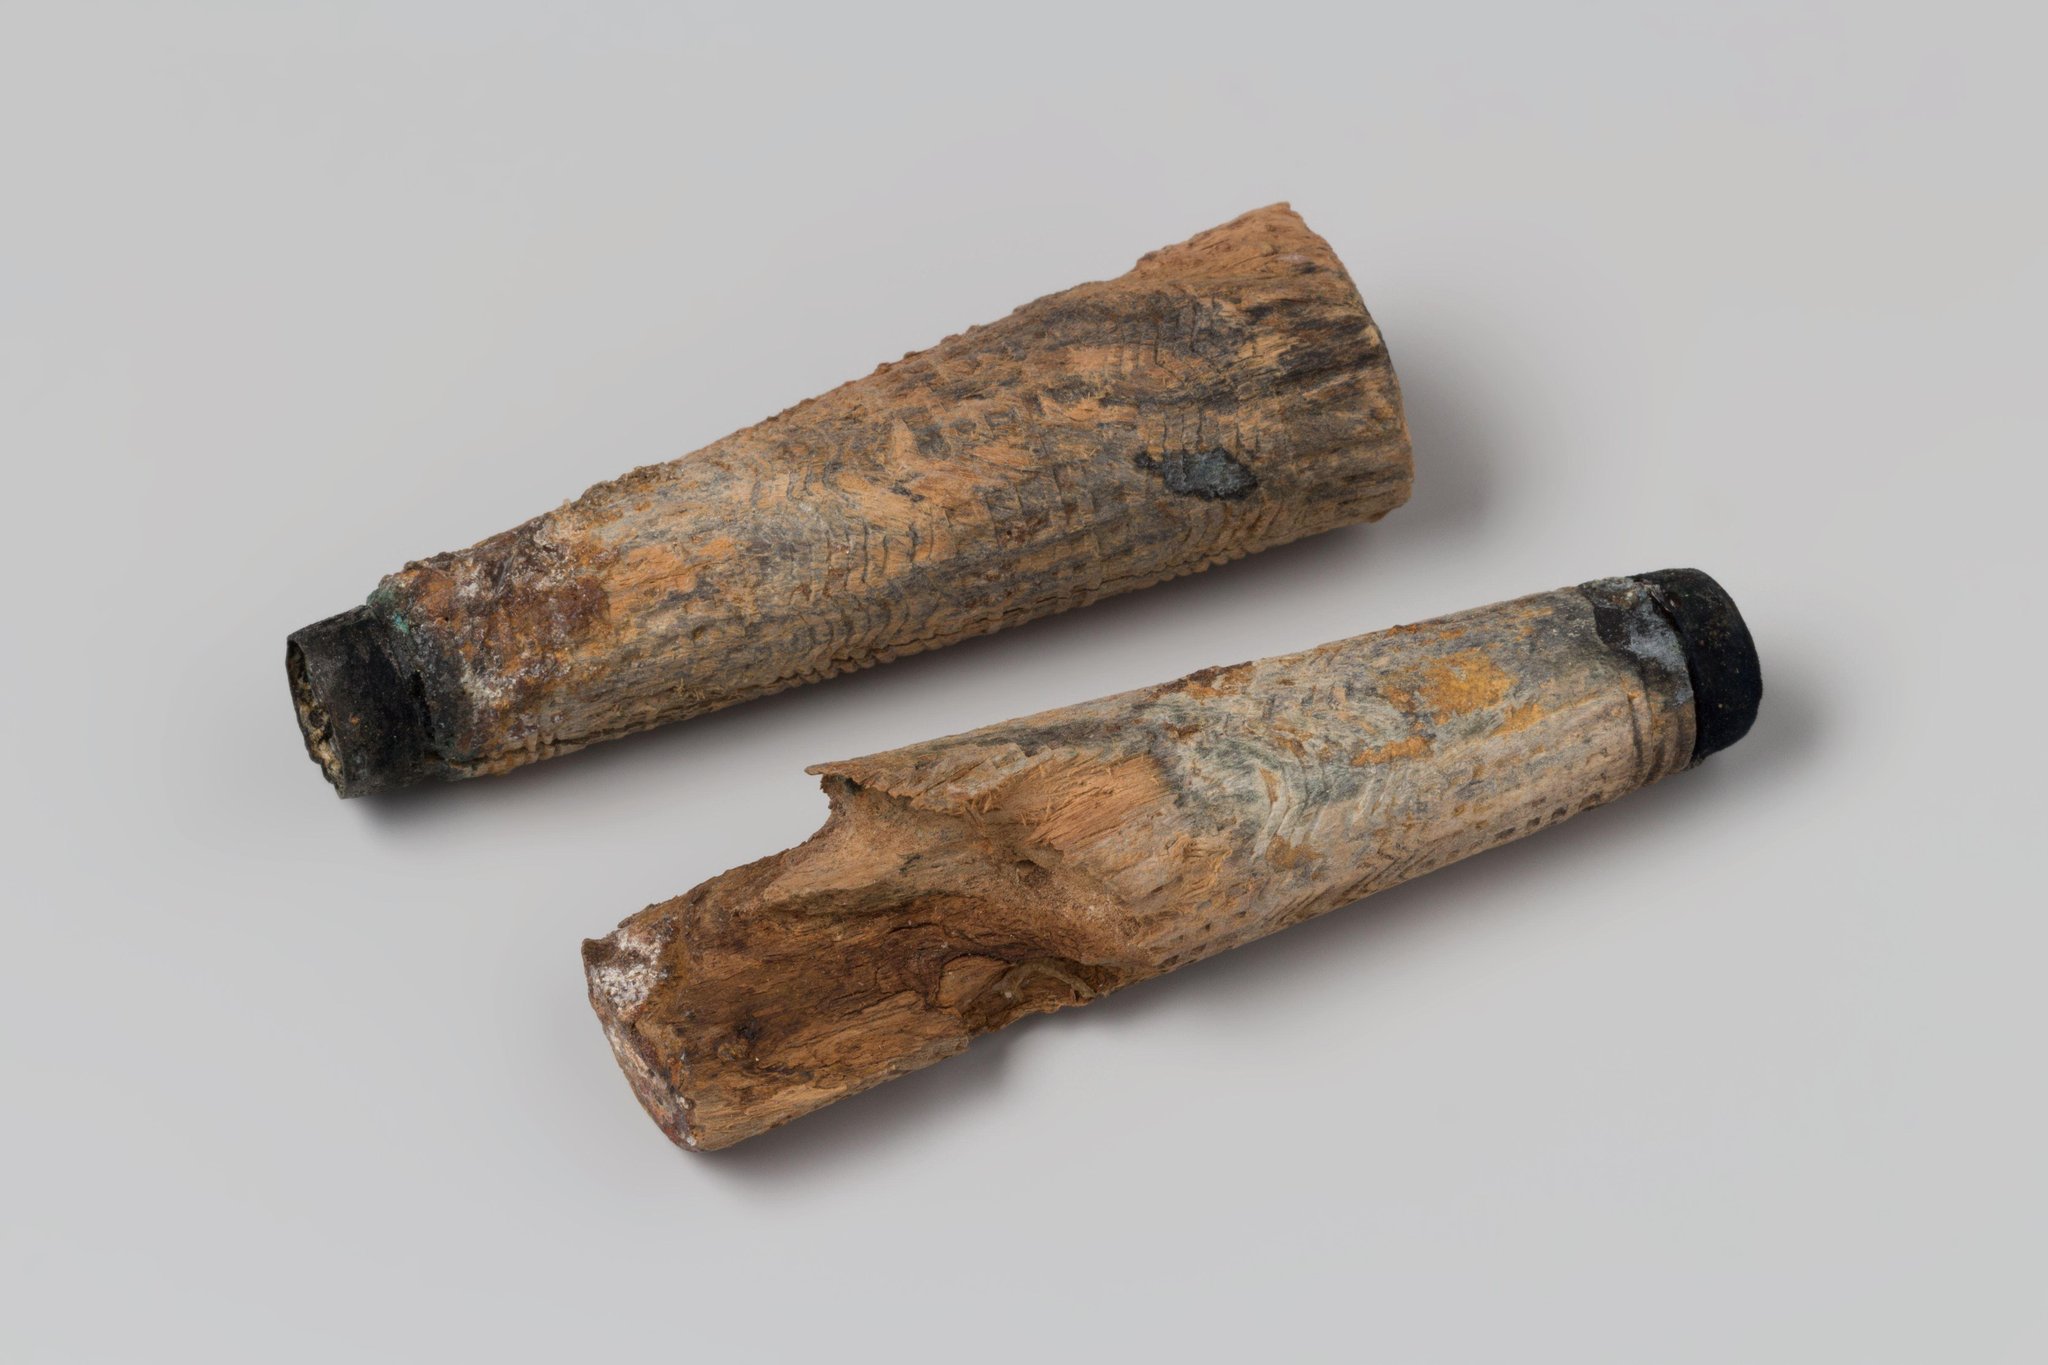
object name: knife handle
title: Messenheften uit het wrak van de Oost-Indiëvaarder Hollandia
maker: Anonymous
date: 1700-1743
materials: copper, wood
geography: netherlands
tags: verenigde oostindische compagnie, hollandia (schip), annet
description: Knife, handle, cylindrical: tapering; id. NG 1979-403H, ferrules, id. NG 1980-27H426.